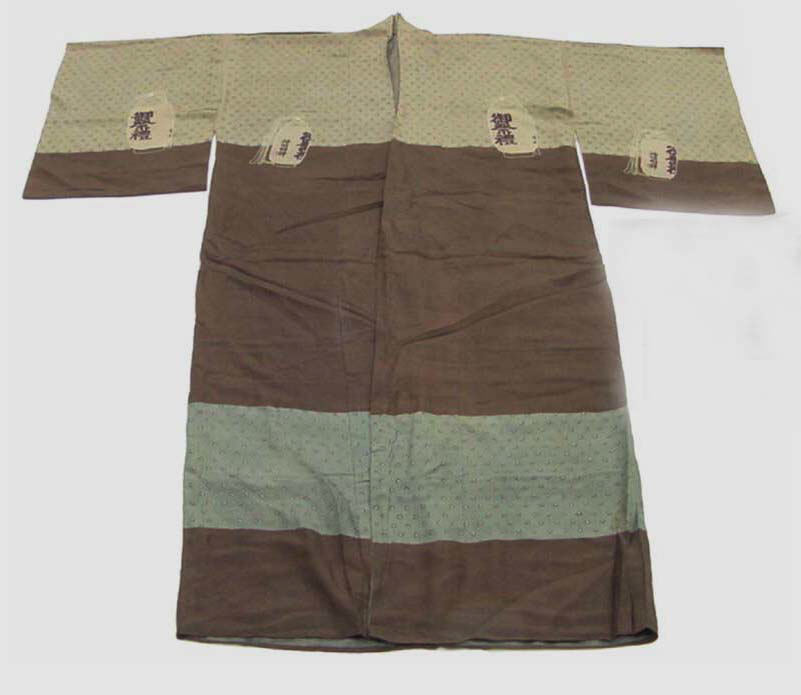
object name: inner garment nagajuban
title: Inner garment (nagajuban)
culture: japanese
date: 1801-1900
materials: silk